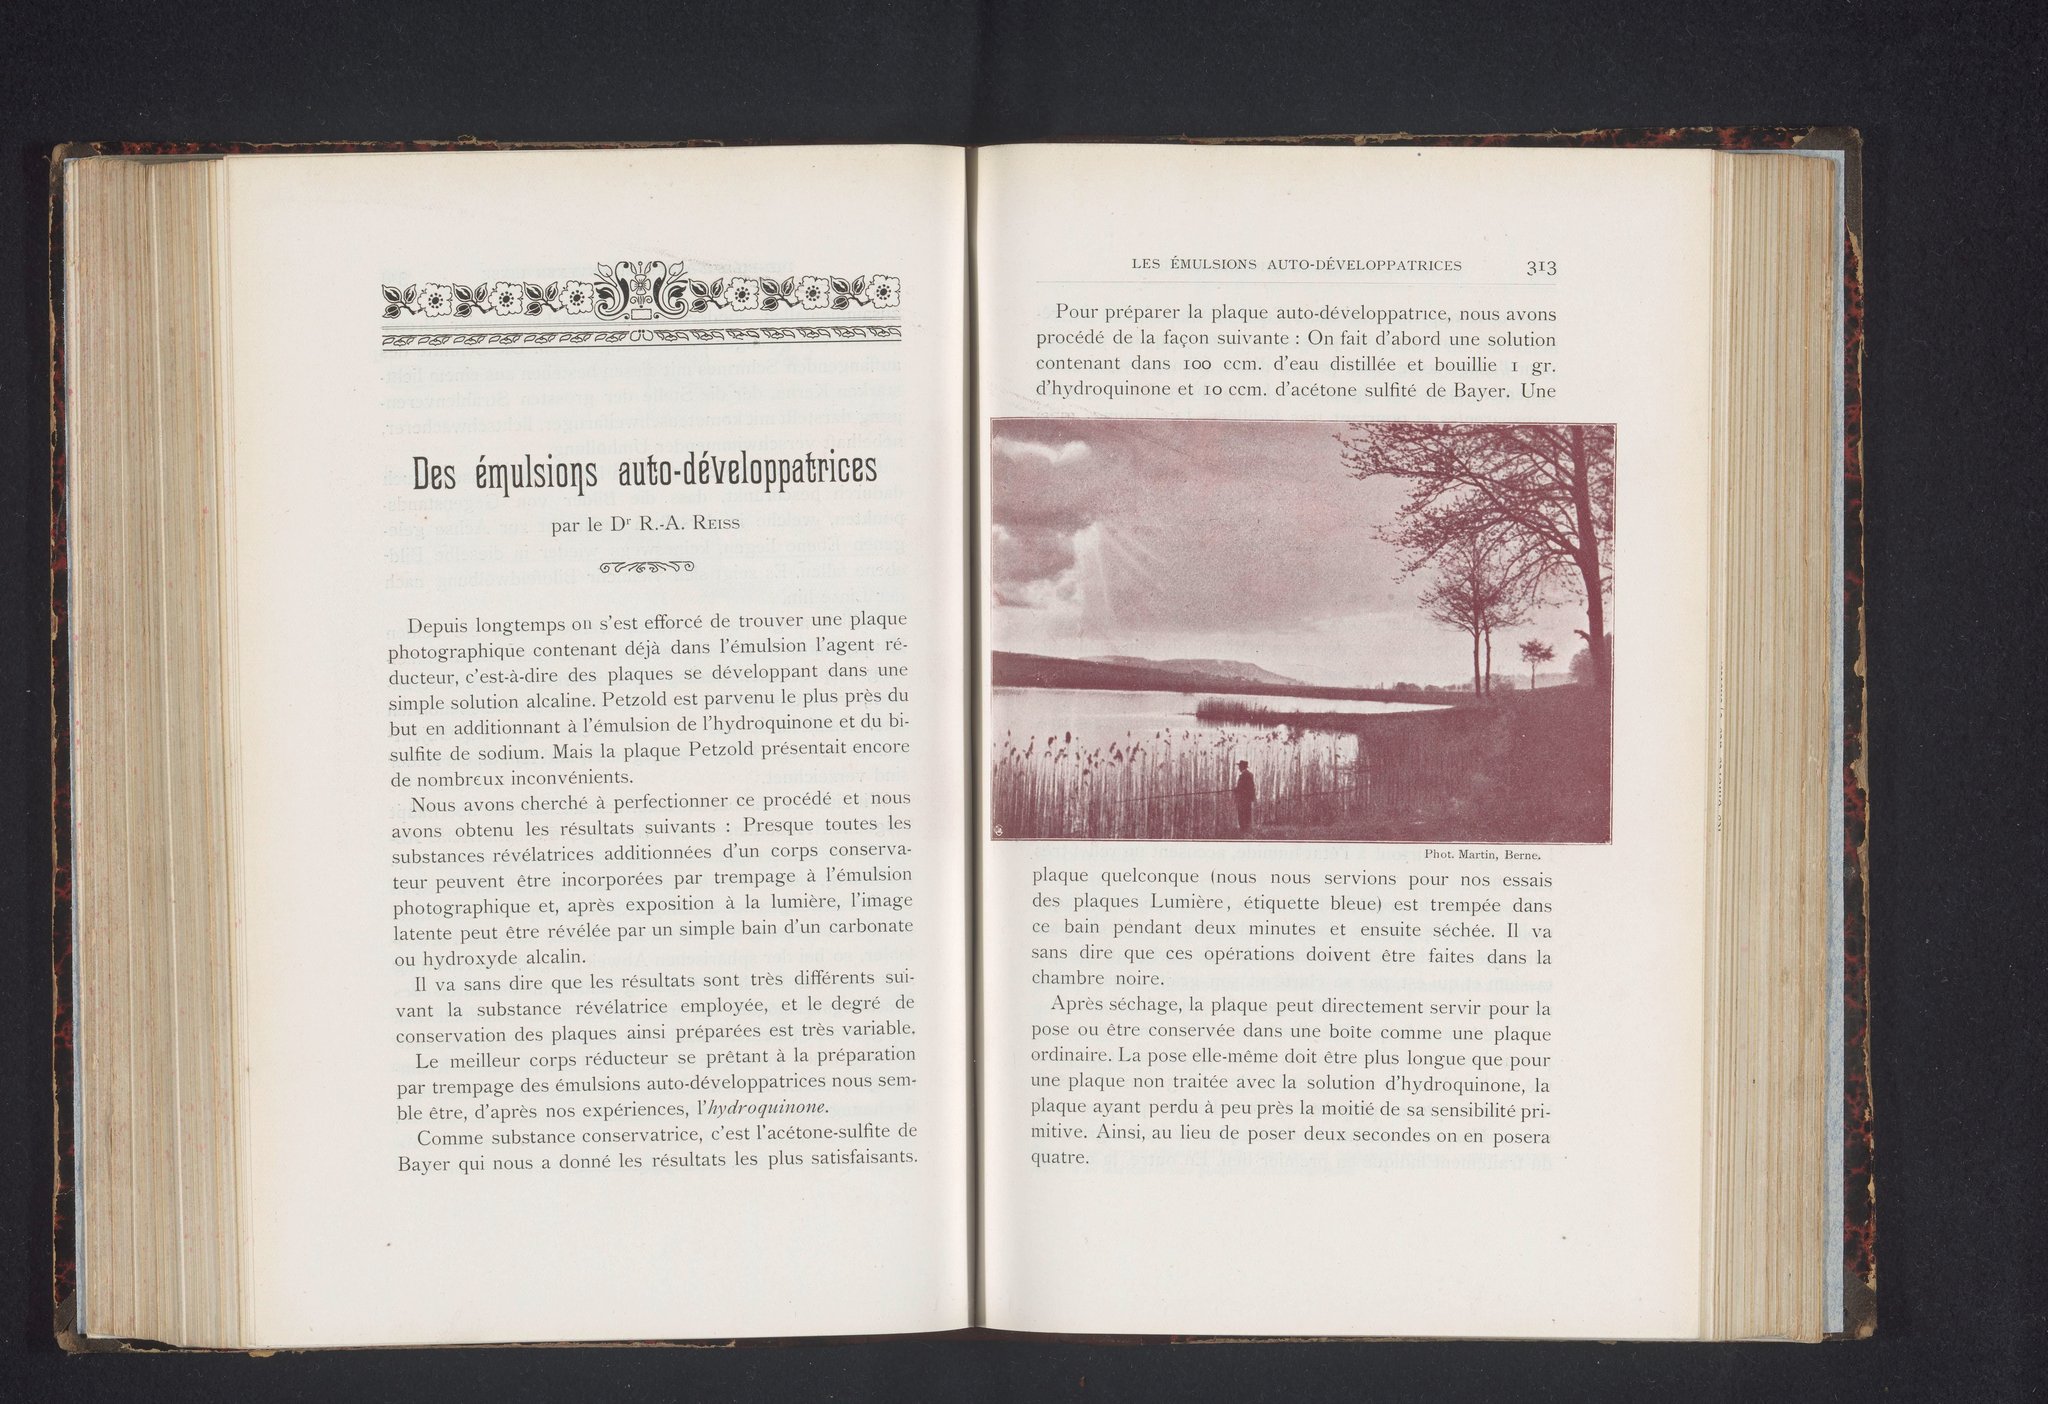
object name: page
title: Landschap met een visser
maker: Anonymous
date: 1897-1902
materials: paper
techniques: autotype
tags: landscapes, fisherman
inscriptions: monogram: ‘C. Cie’, inscription: ‘Phot. Martin, Berne’